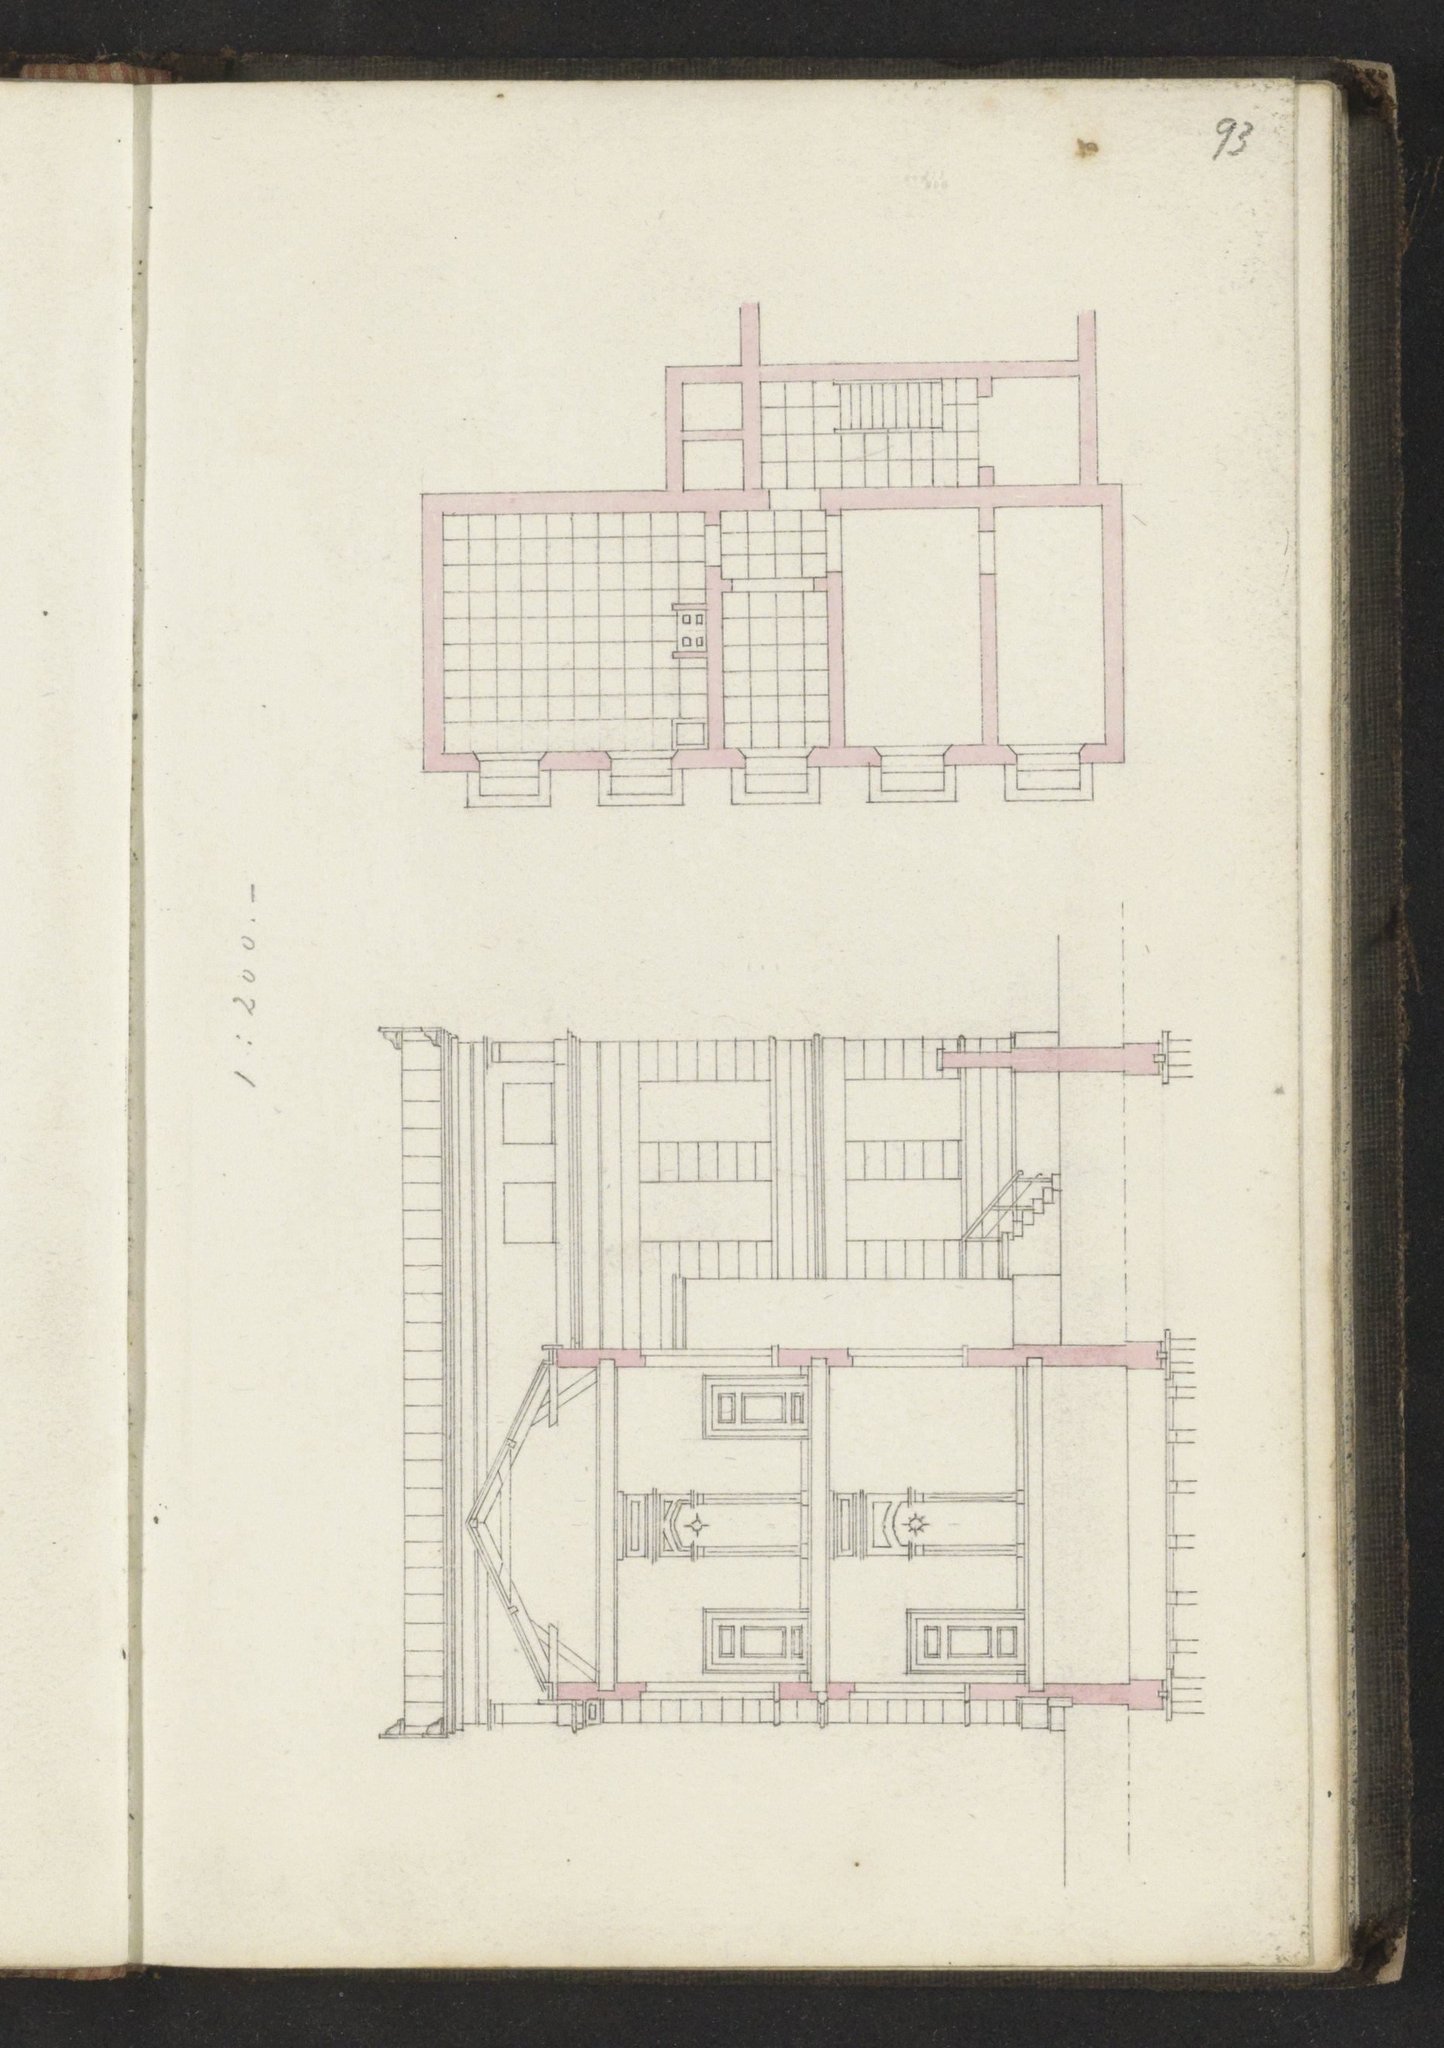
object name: sketchbook leaf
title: Achteraanzicht en plattegrond van een gebouw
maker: willem springer jr.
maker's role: draughtsman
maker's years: 1815-1907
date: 1864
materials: ink, paper, pencil, watercolor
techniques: brush, pen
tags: rear façade, plan ~ architecture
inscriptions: annotation: ‘1 : 200.-’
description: Pagina 93 uit een schetsboek met 164 pagina's.